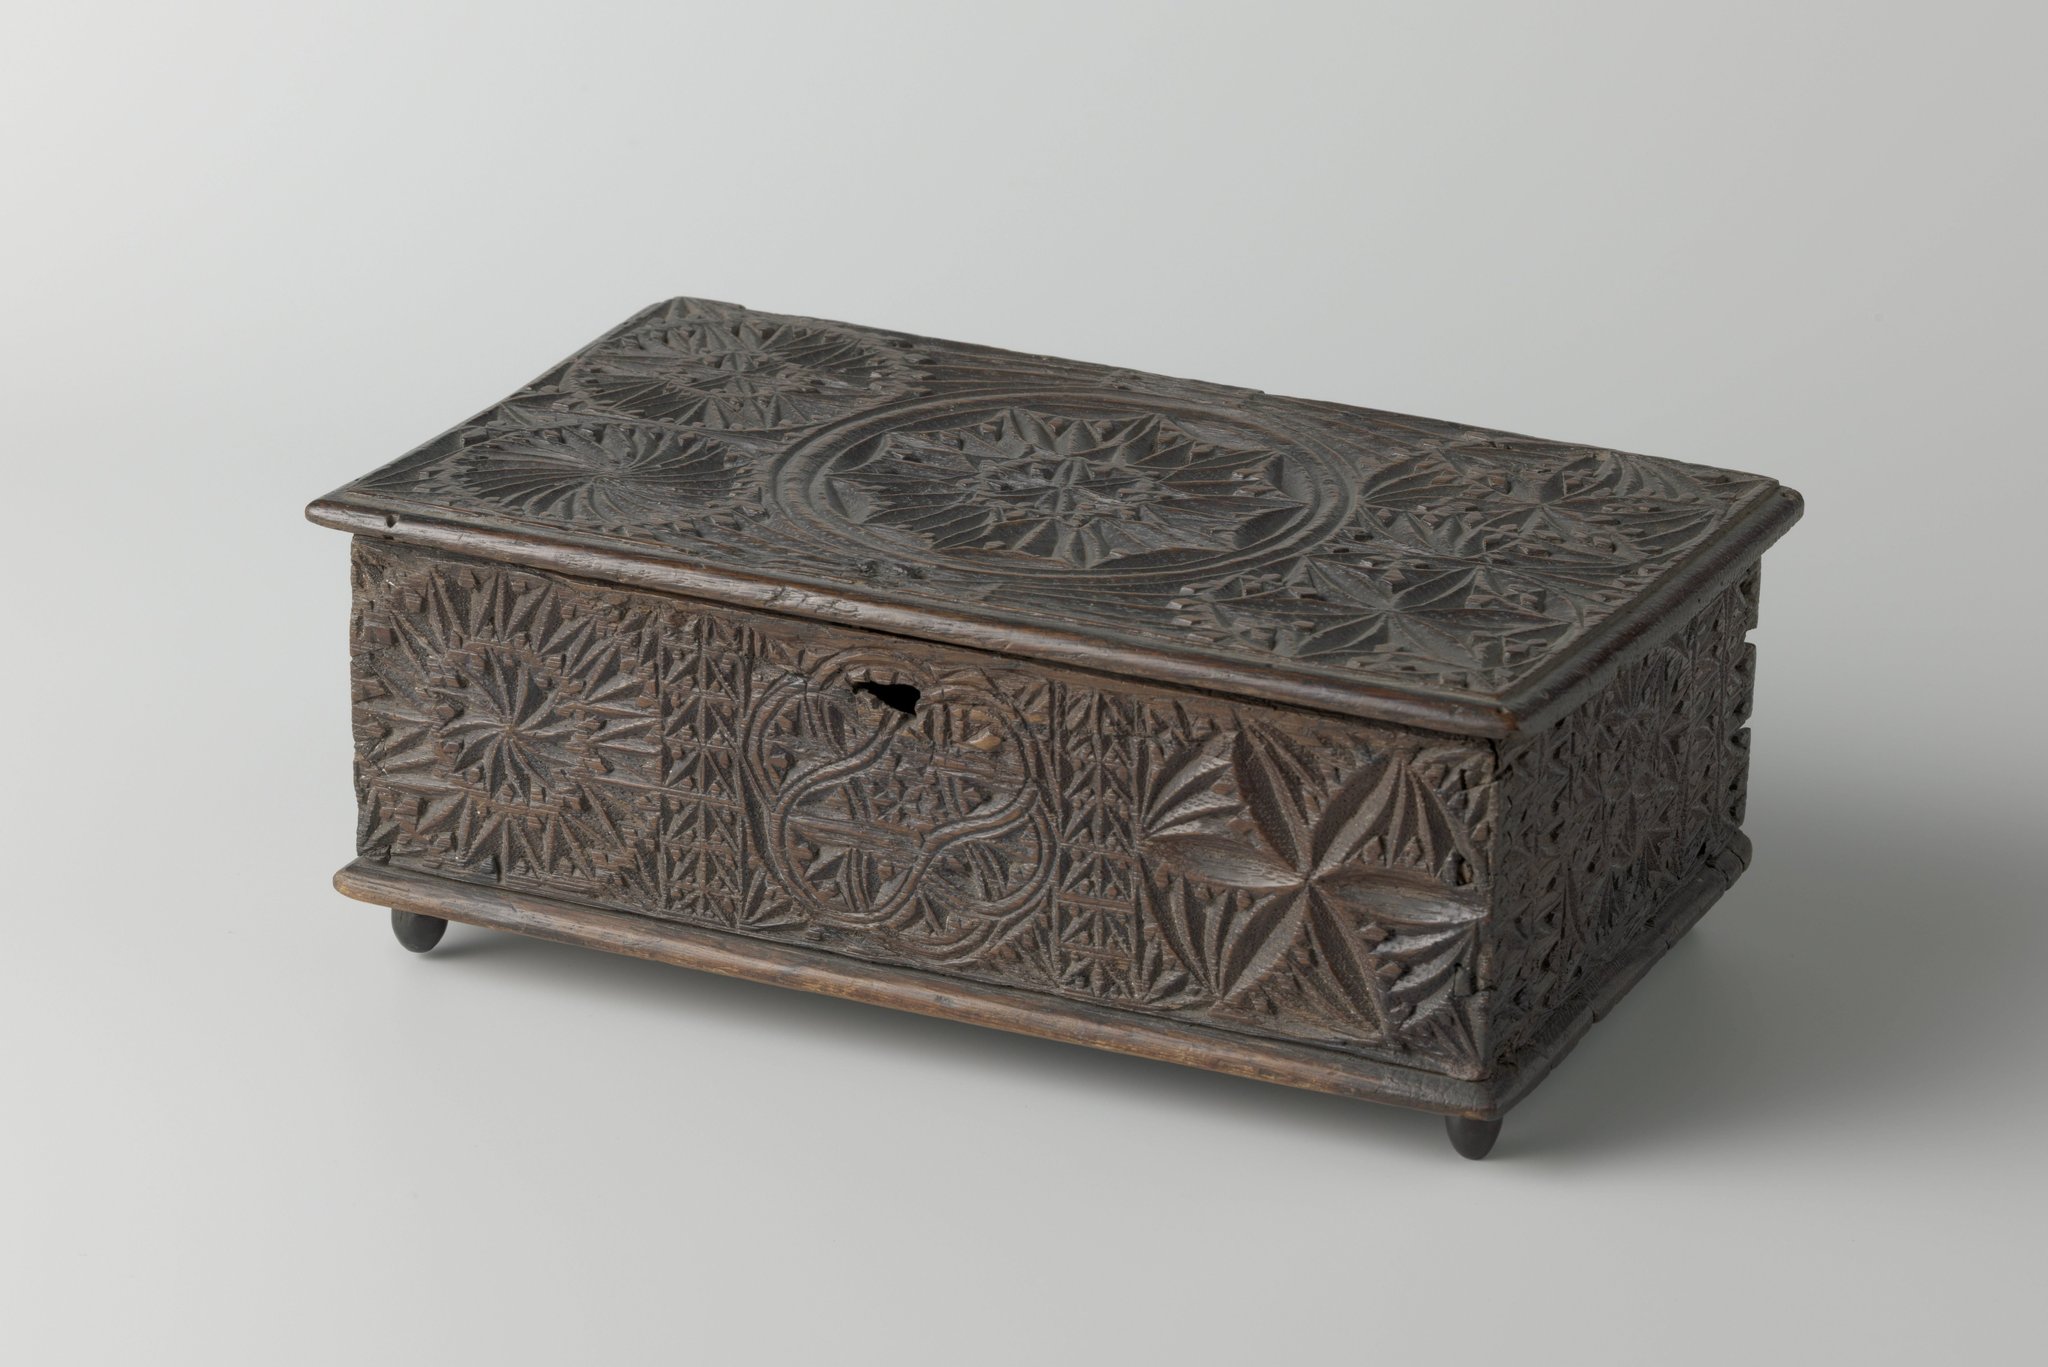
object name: chest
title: Kist versierd met kerfsnee ornamenten waaronder een vaas met tulp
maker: Anonymous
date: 1700-1799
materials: wood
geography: netherlands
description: Kist, versierd met kerfsnee ornamenten. Het achterband vertoont een effen veld waarop restanten van groene verf en aan de beide uiteinden een vaas met tulp. Het kist rust op kleine ebbenhouten eikelvormige poten. Inwendig drie vakken. Het slot ontbreekt.